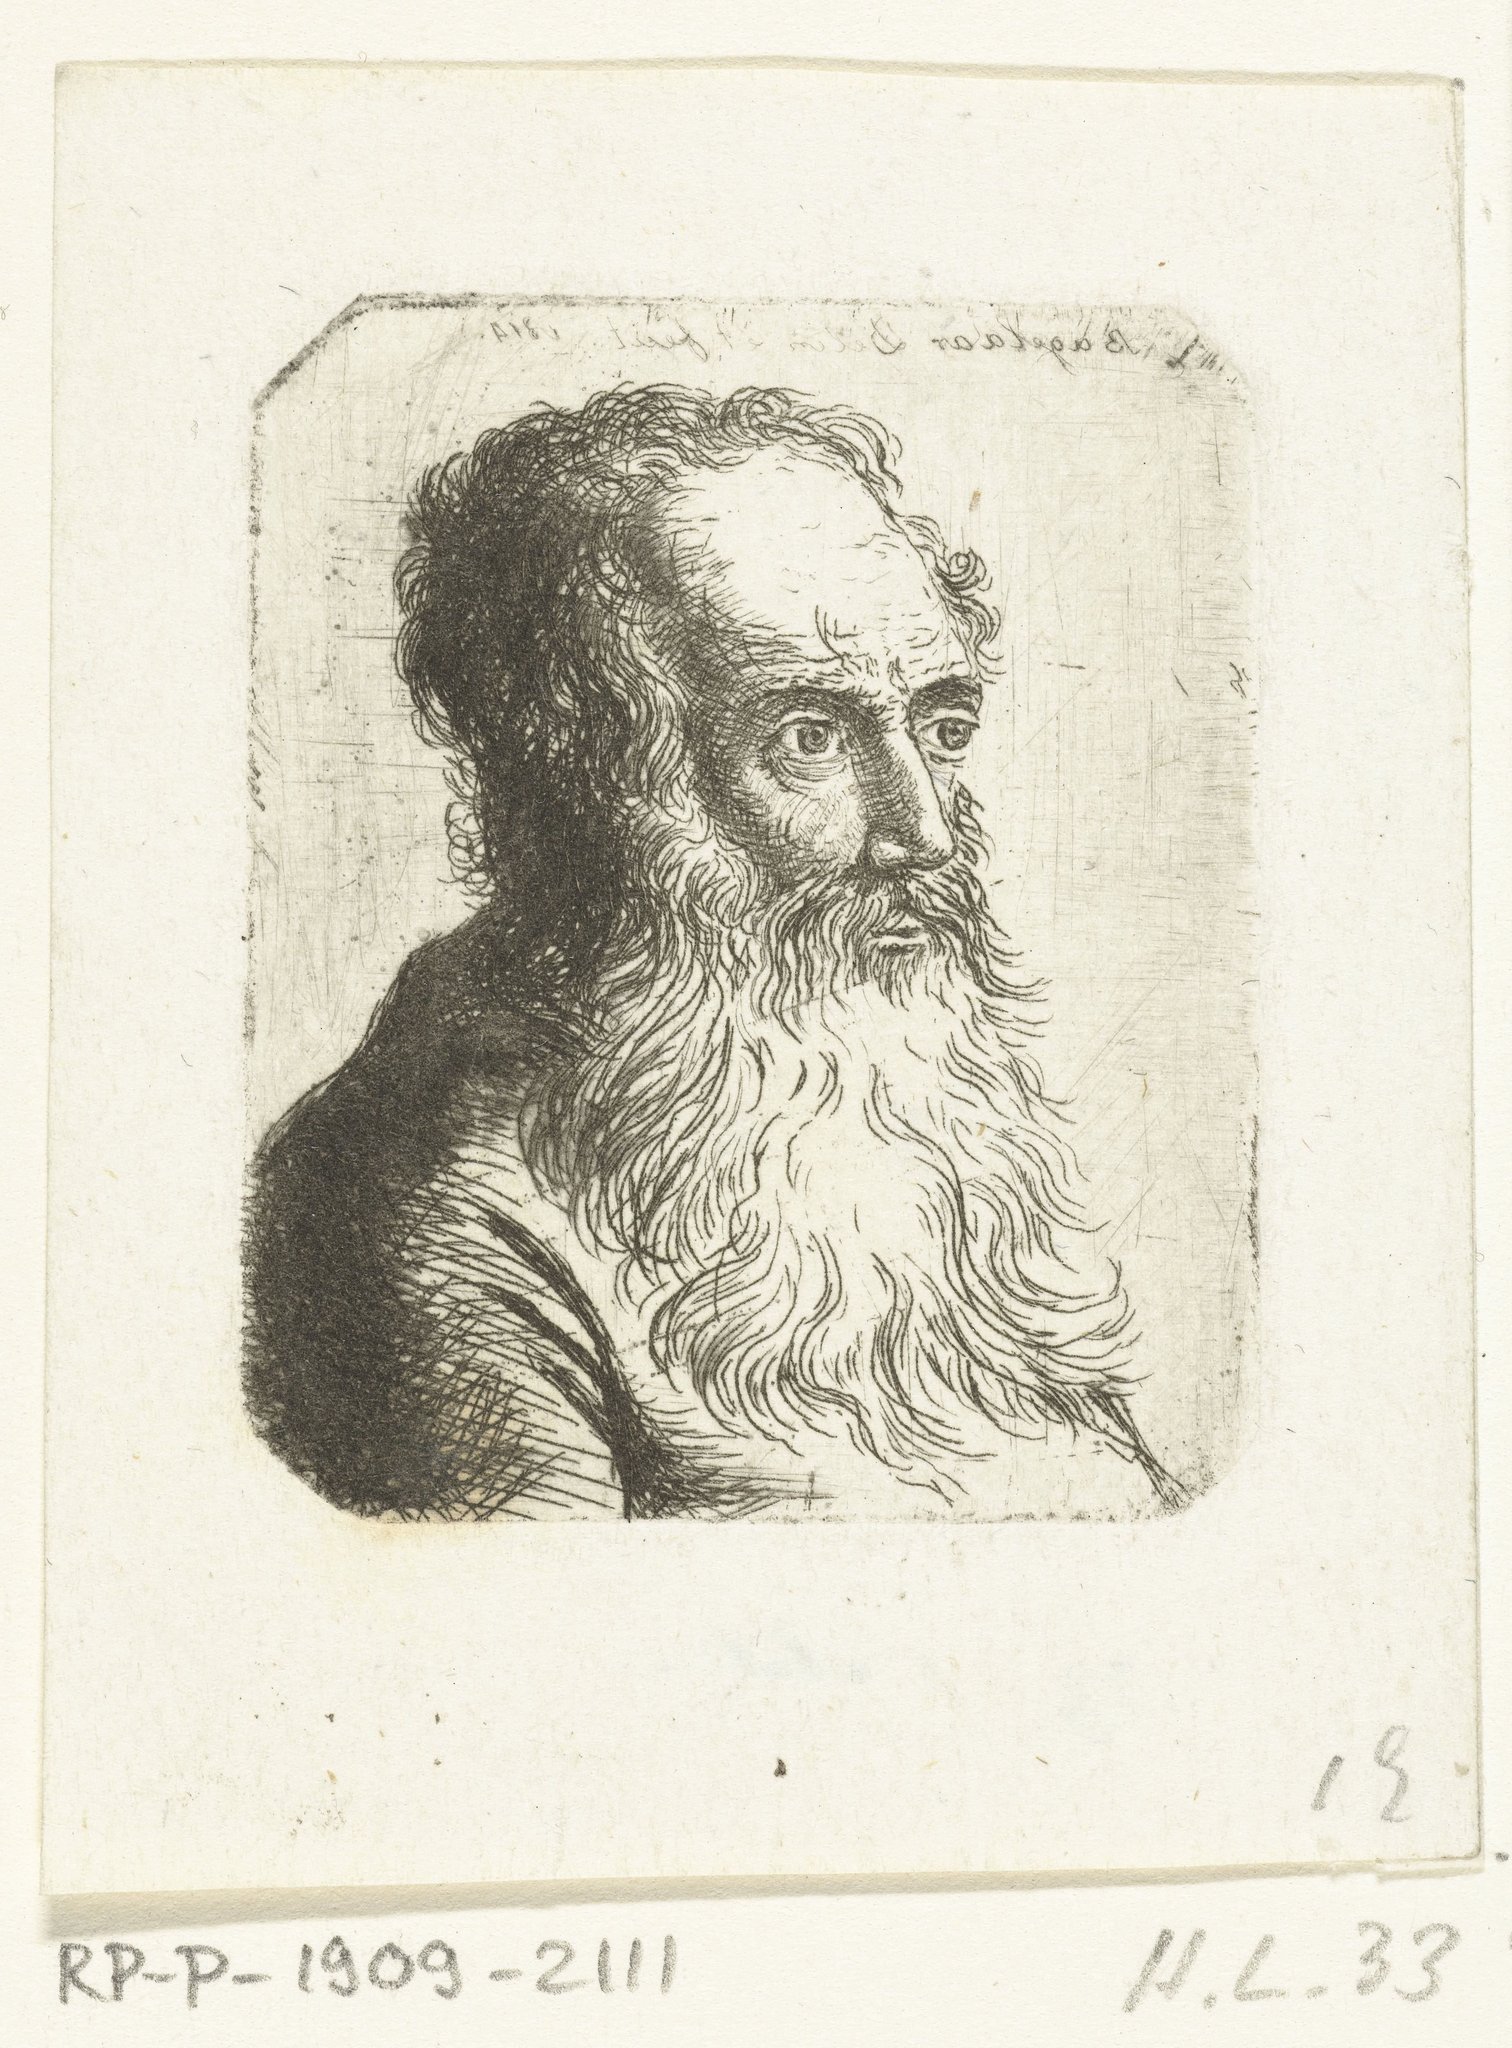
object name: print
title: Portretbuste van een oude man met baard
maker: ernst willem jan bagelaar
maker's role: draughtsman, print maker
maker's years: 1775-1837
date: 1798-1837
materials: paper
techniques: drypoint, etching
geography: netherlands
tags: old man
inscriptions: collector's mark: Lugt 2228